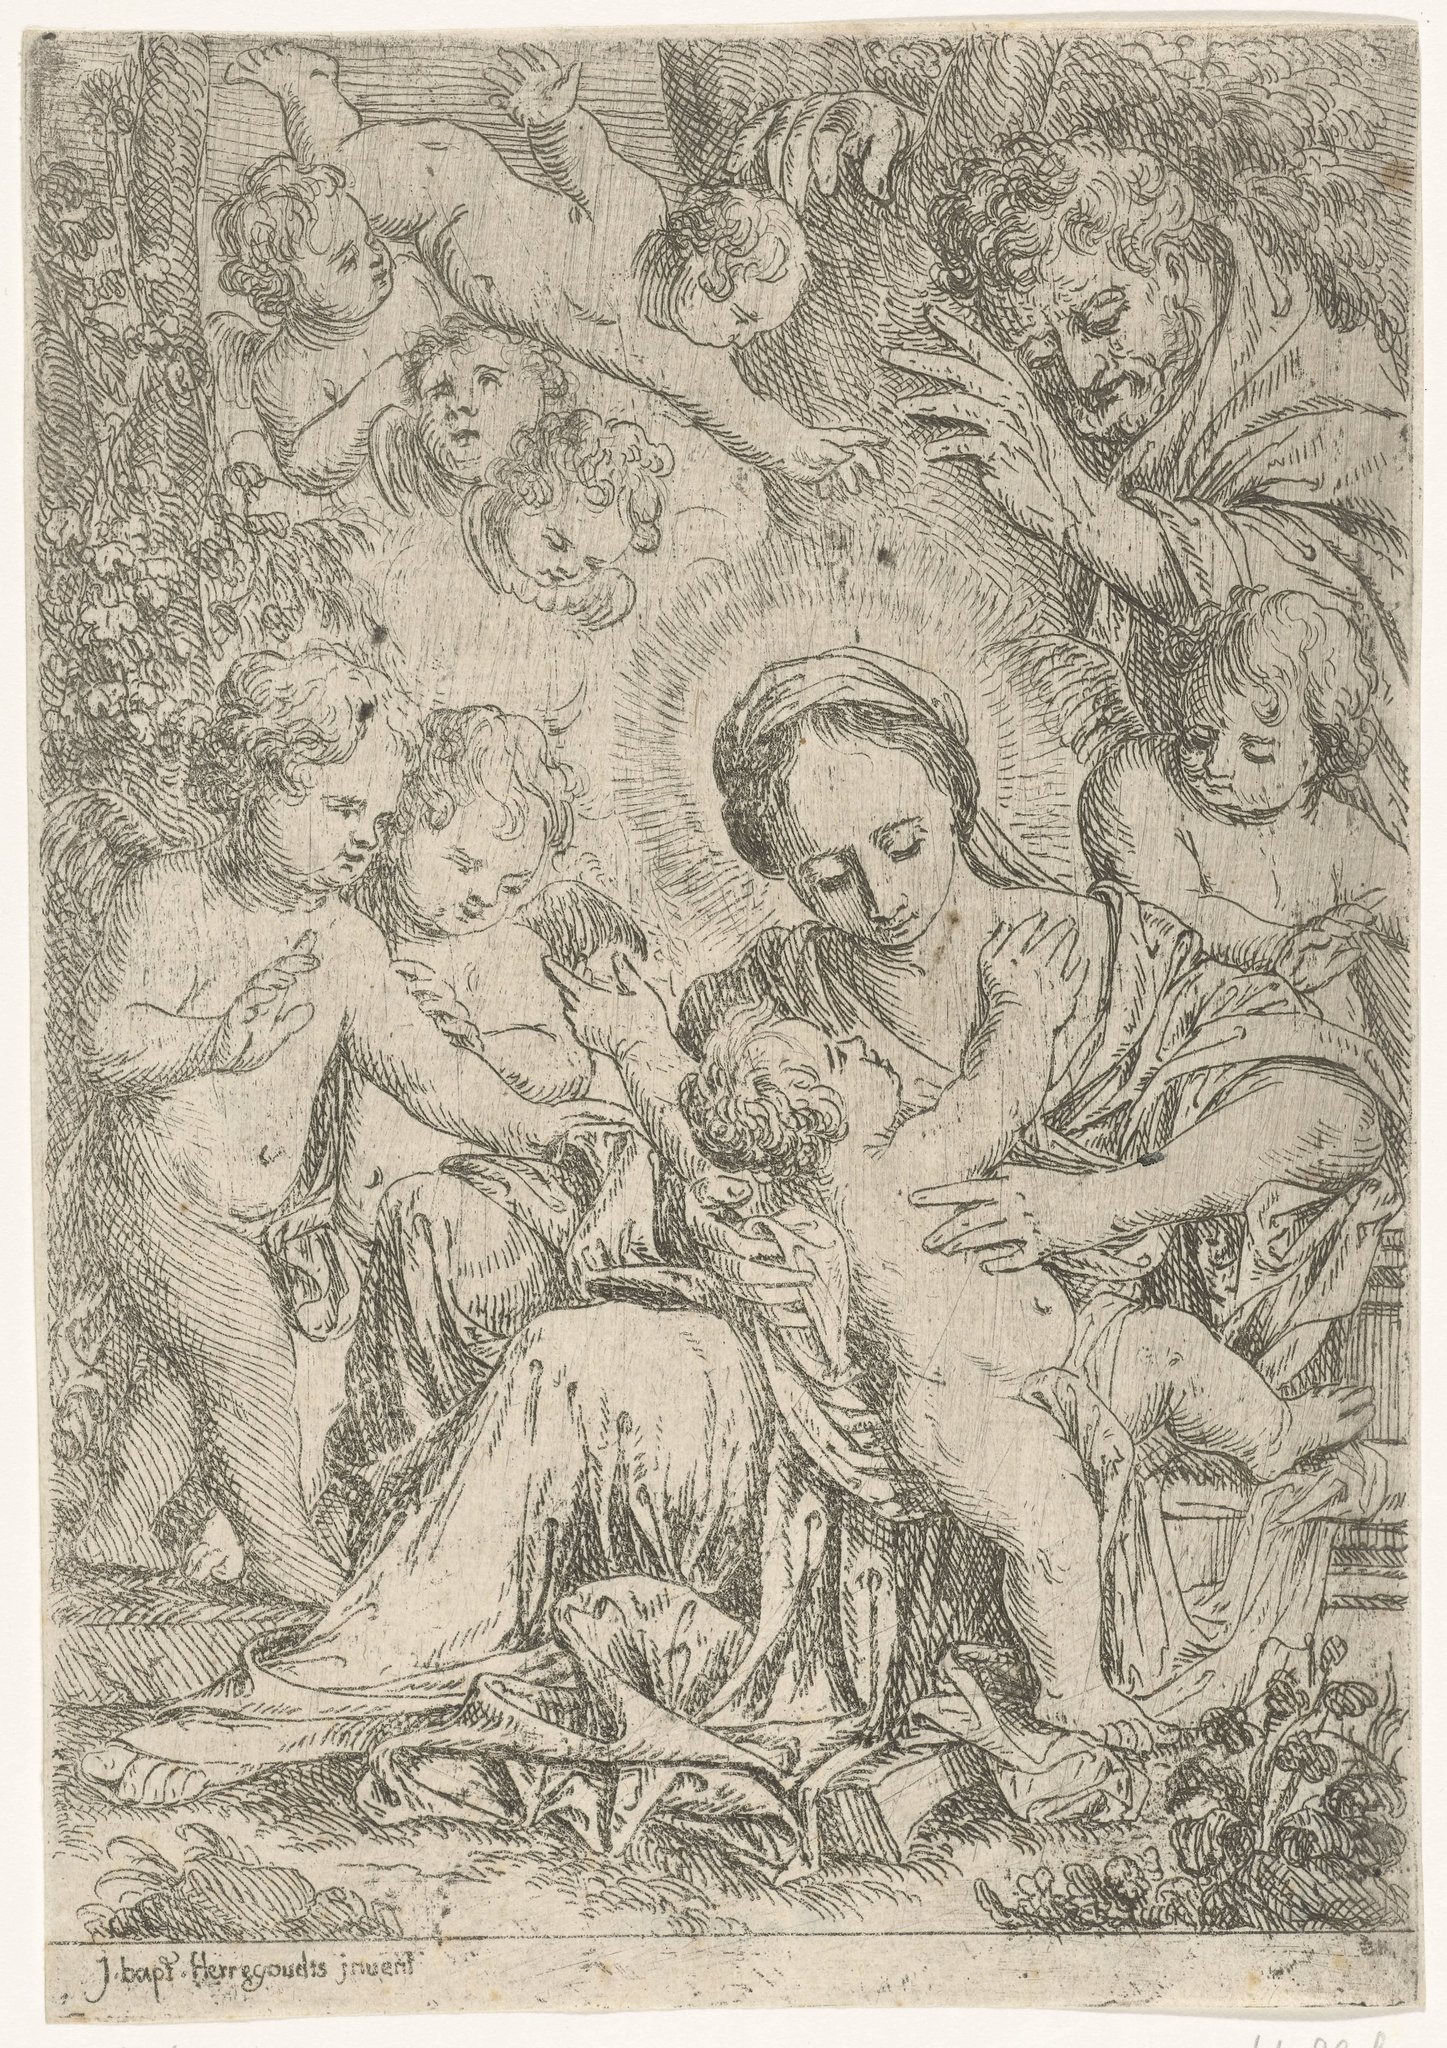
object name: print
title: De Heilige Familie met engelen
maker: jan baptist herregouts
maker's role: print maker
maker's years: 1640-1721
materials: paper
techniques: etching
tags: holy family, and derived representations (+ angel(s))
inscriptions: collector's mark: Lugt 2165